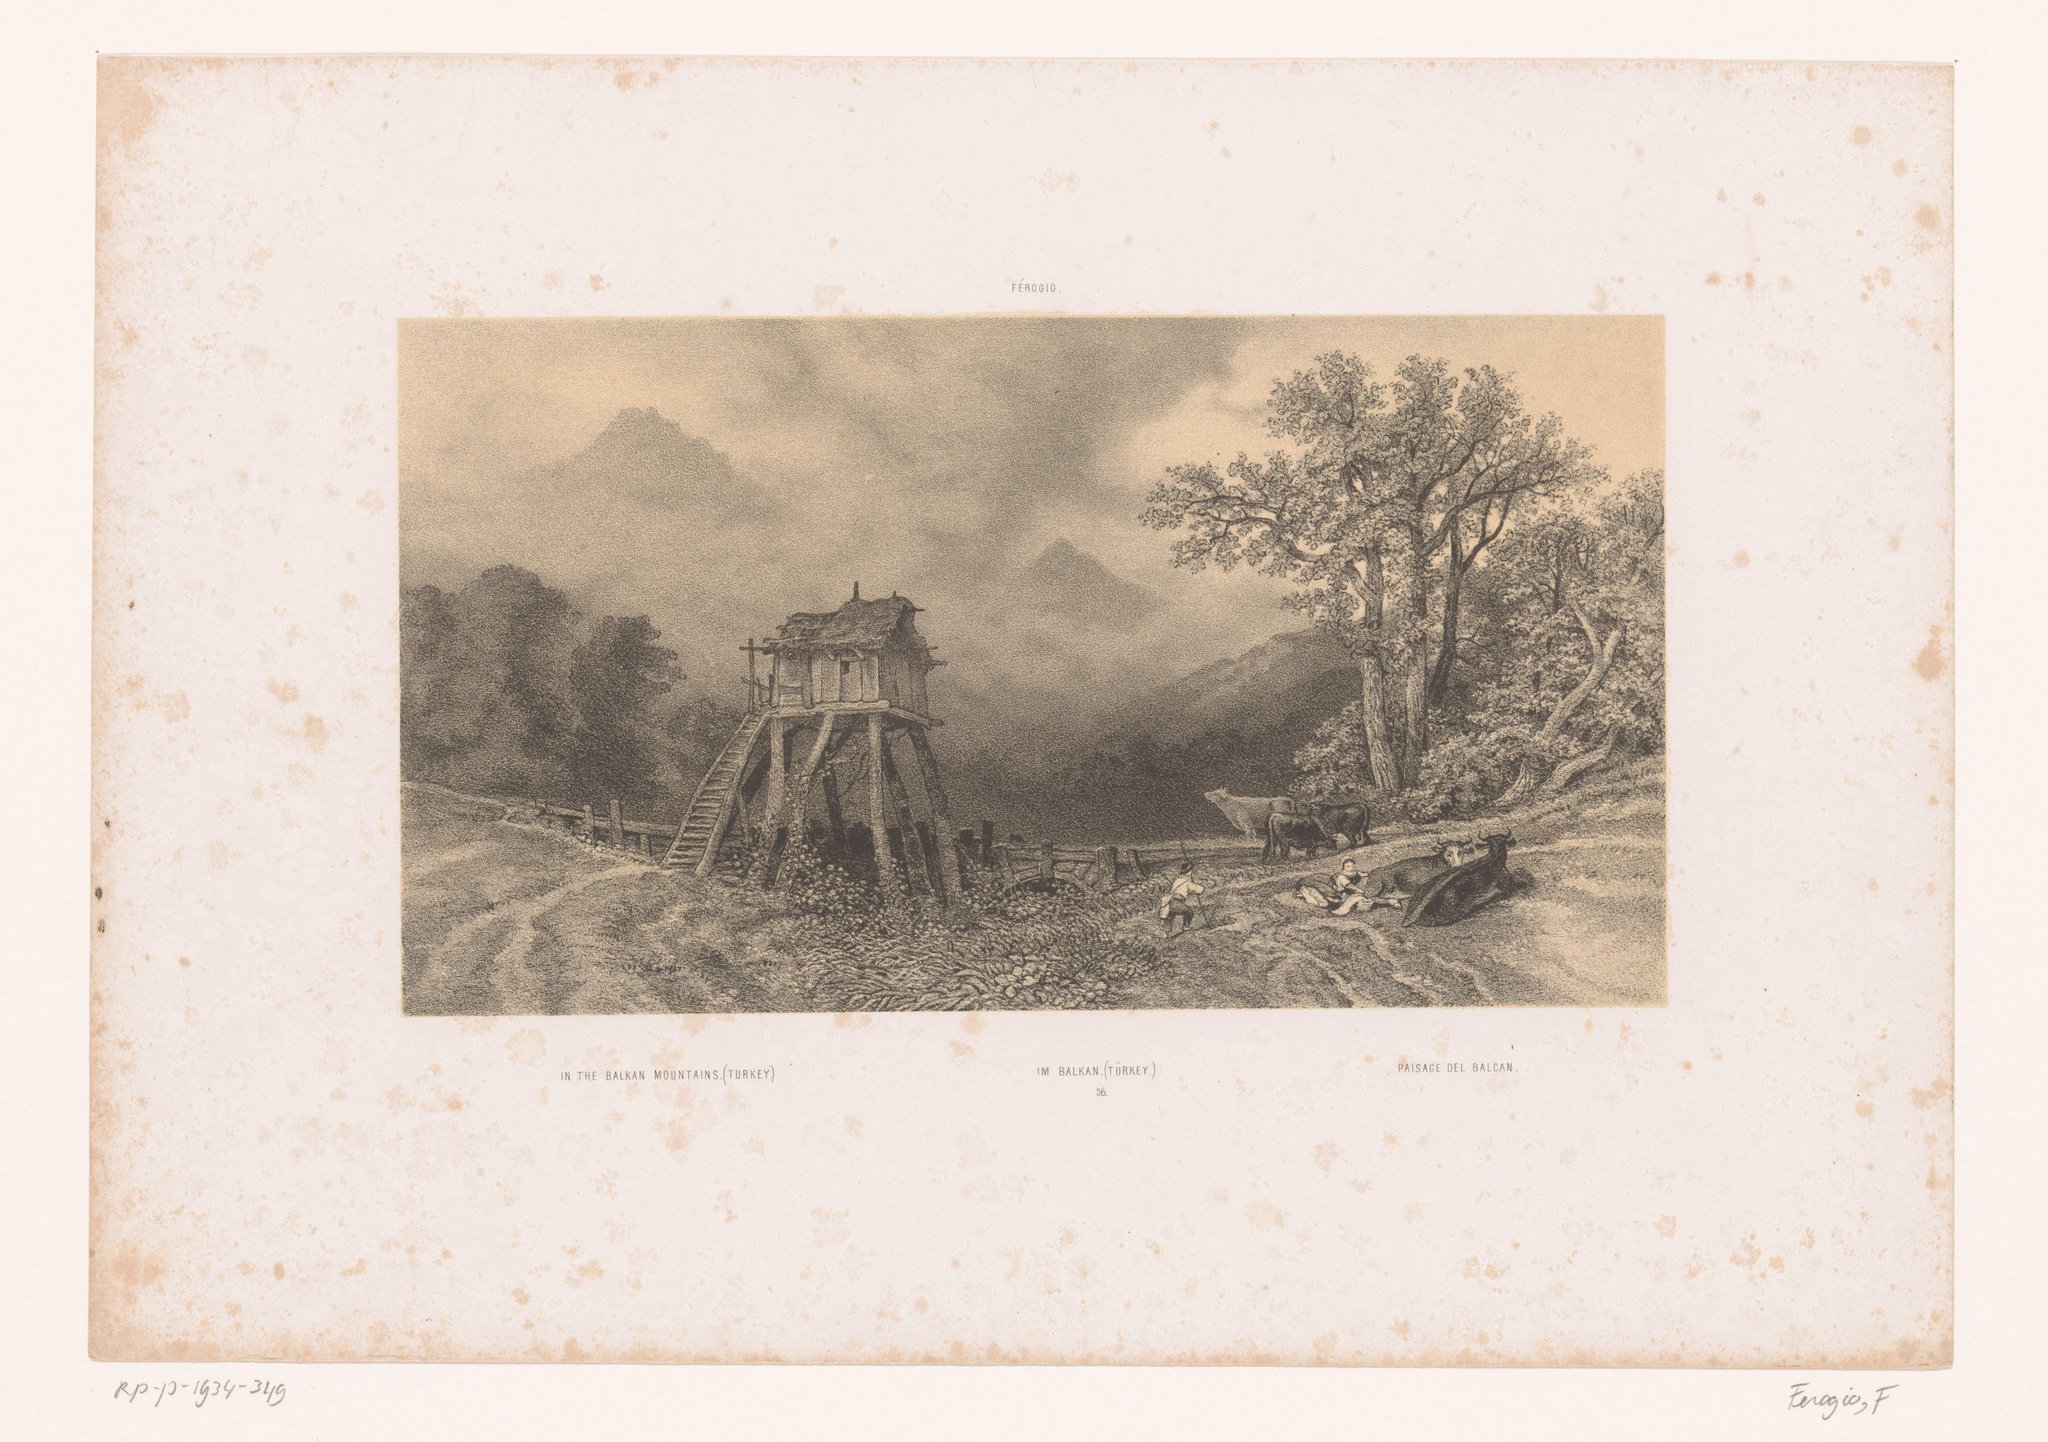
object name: print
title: Landschap met hut, koeien en herders in de Balkan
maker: fortuné férogio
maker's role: print maker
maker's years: 1805-1888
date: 1829-1875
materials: paper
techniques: tone lithography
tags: herding, herdsman, herdswoman, shepherd, shepherdess, cowherd, etc., mountains (+ landscape with figures, staffage), hut, cabin, lodge